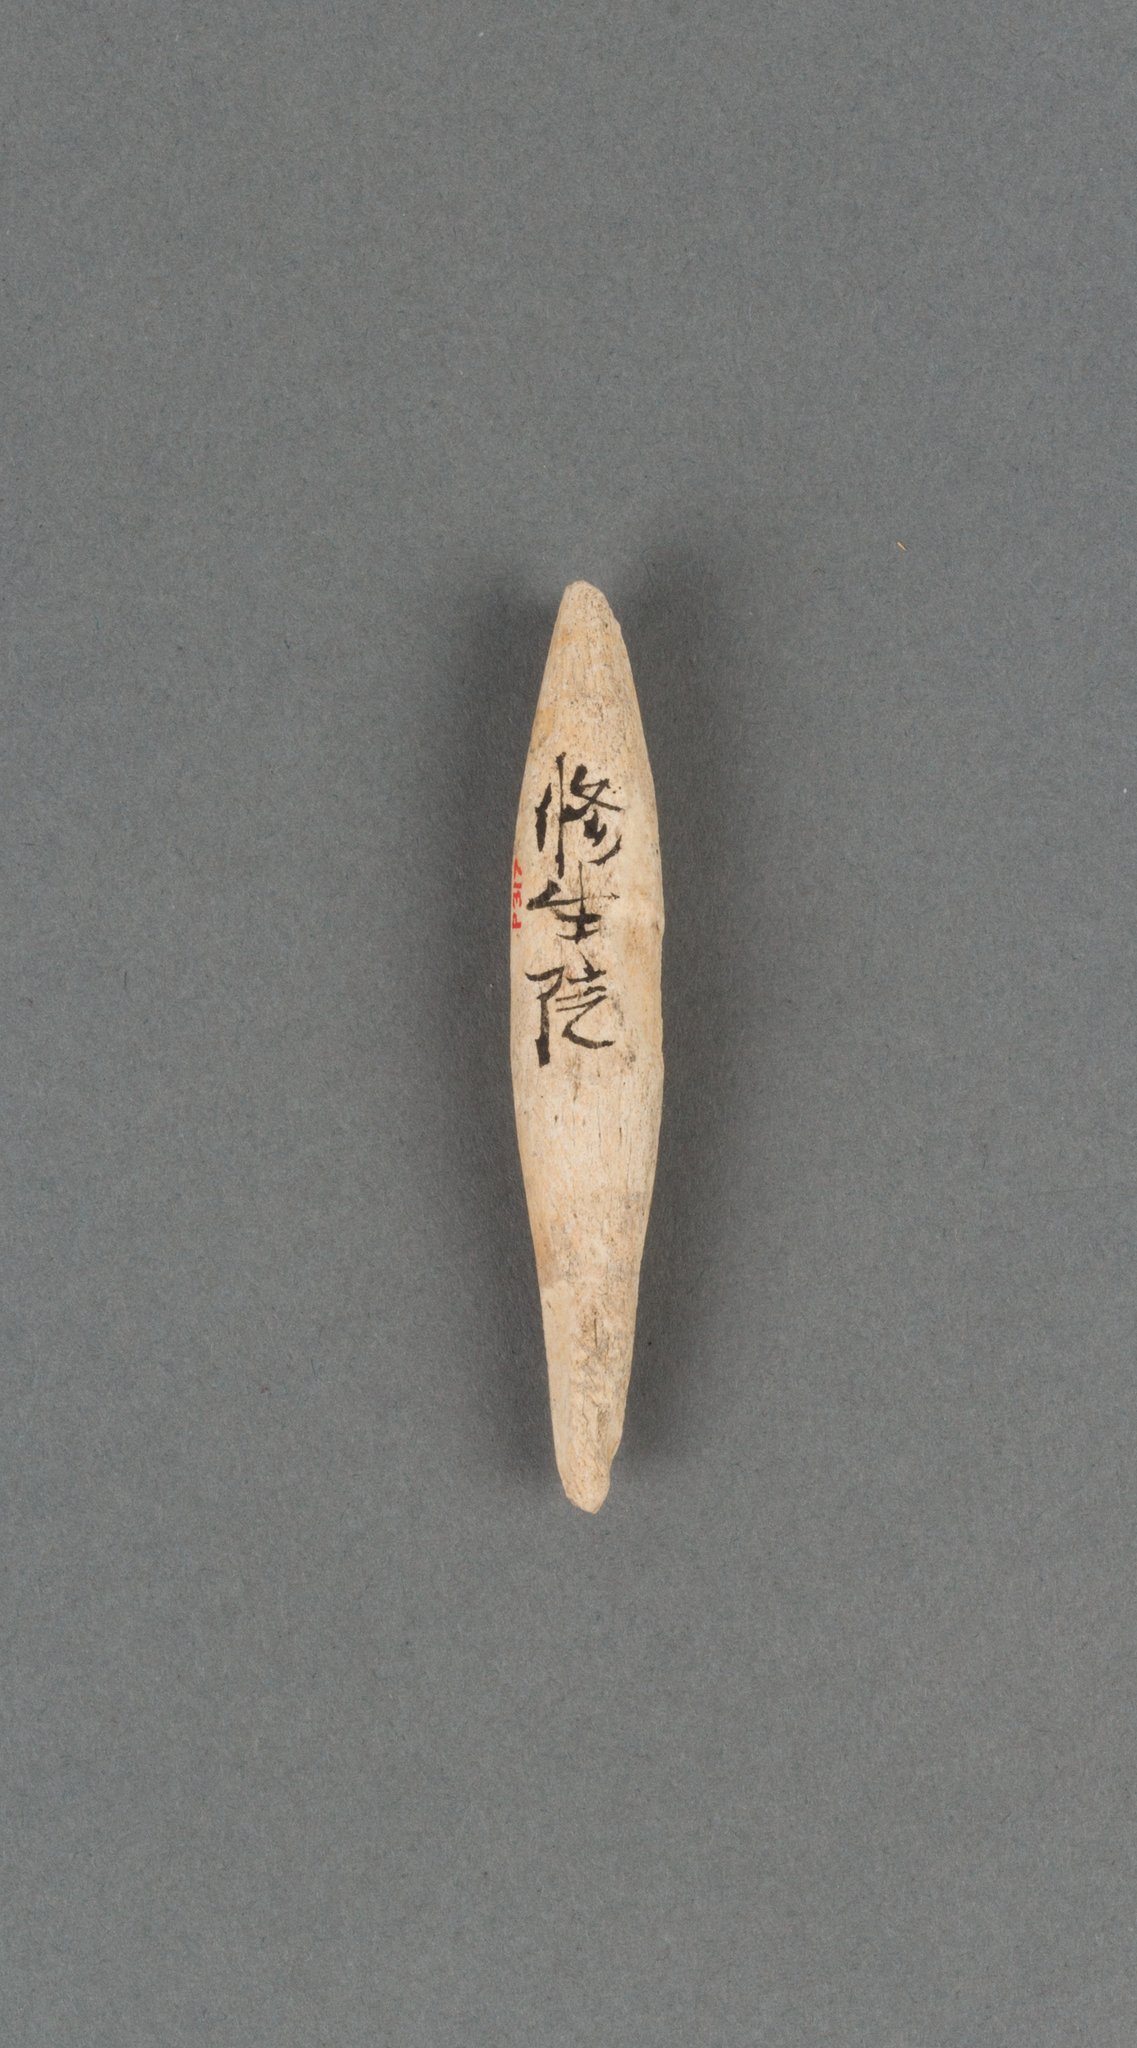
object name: harpoon head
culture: japanese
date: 1200-200 BCE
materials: bone